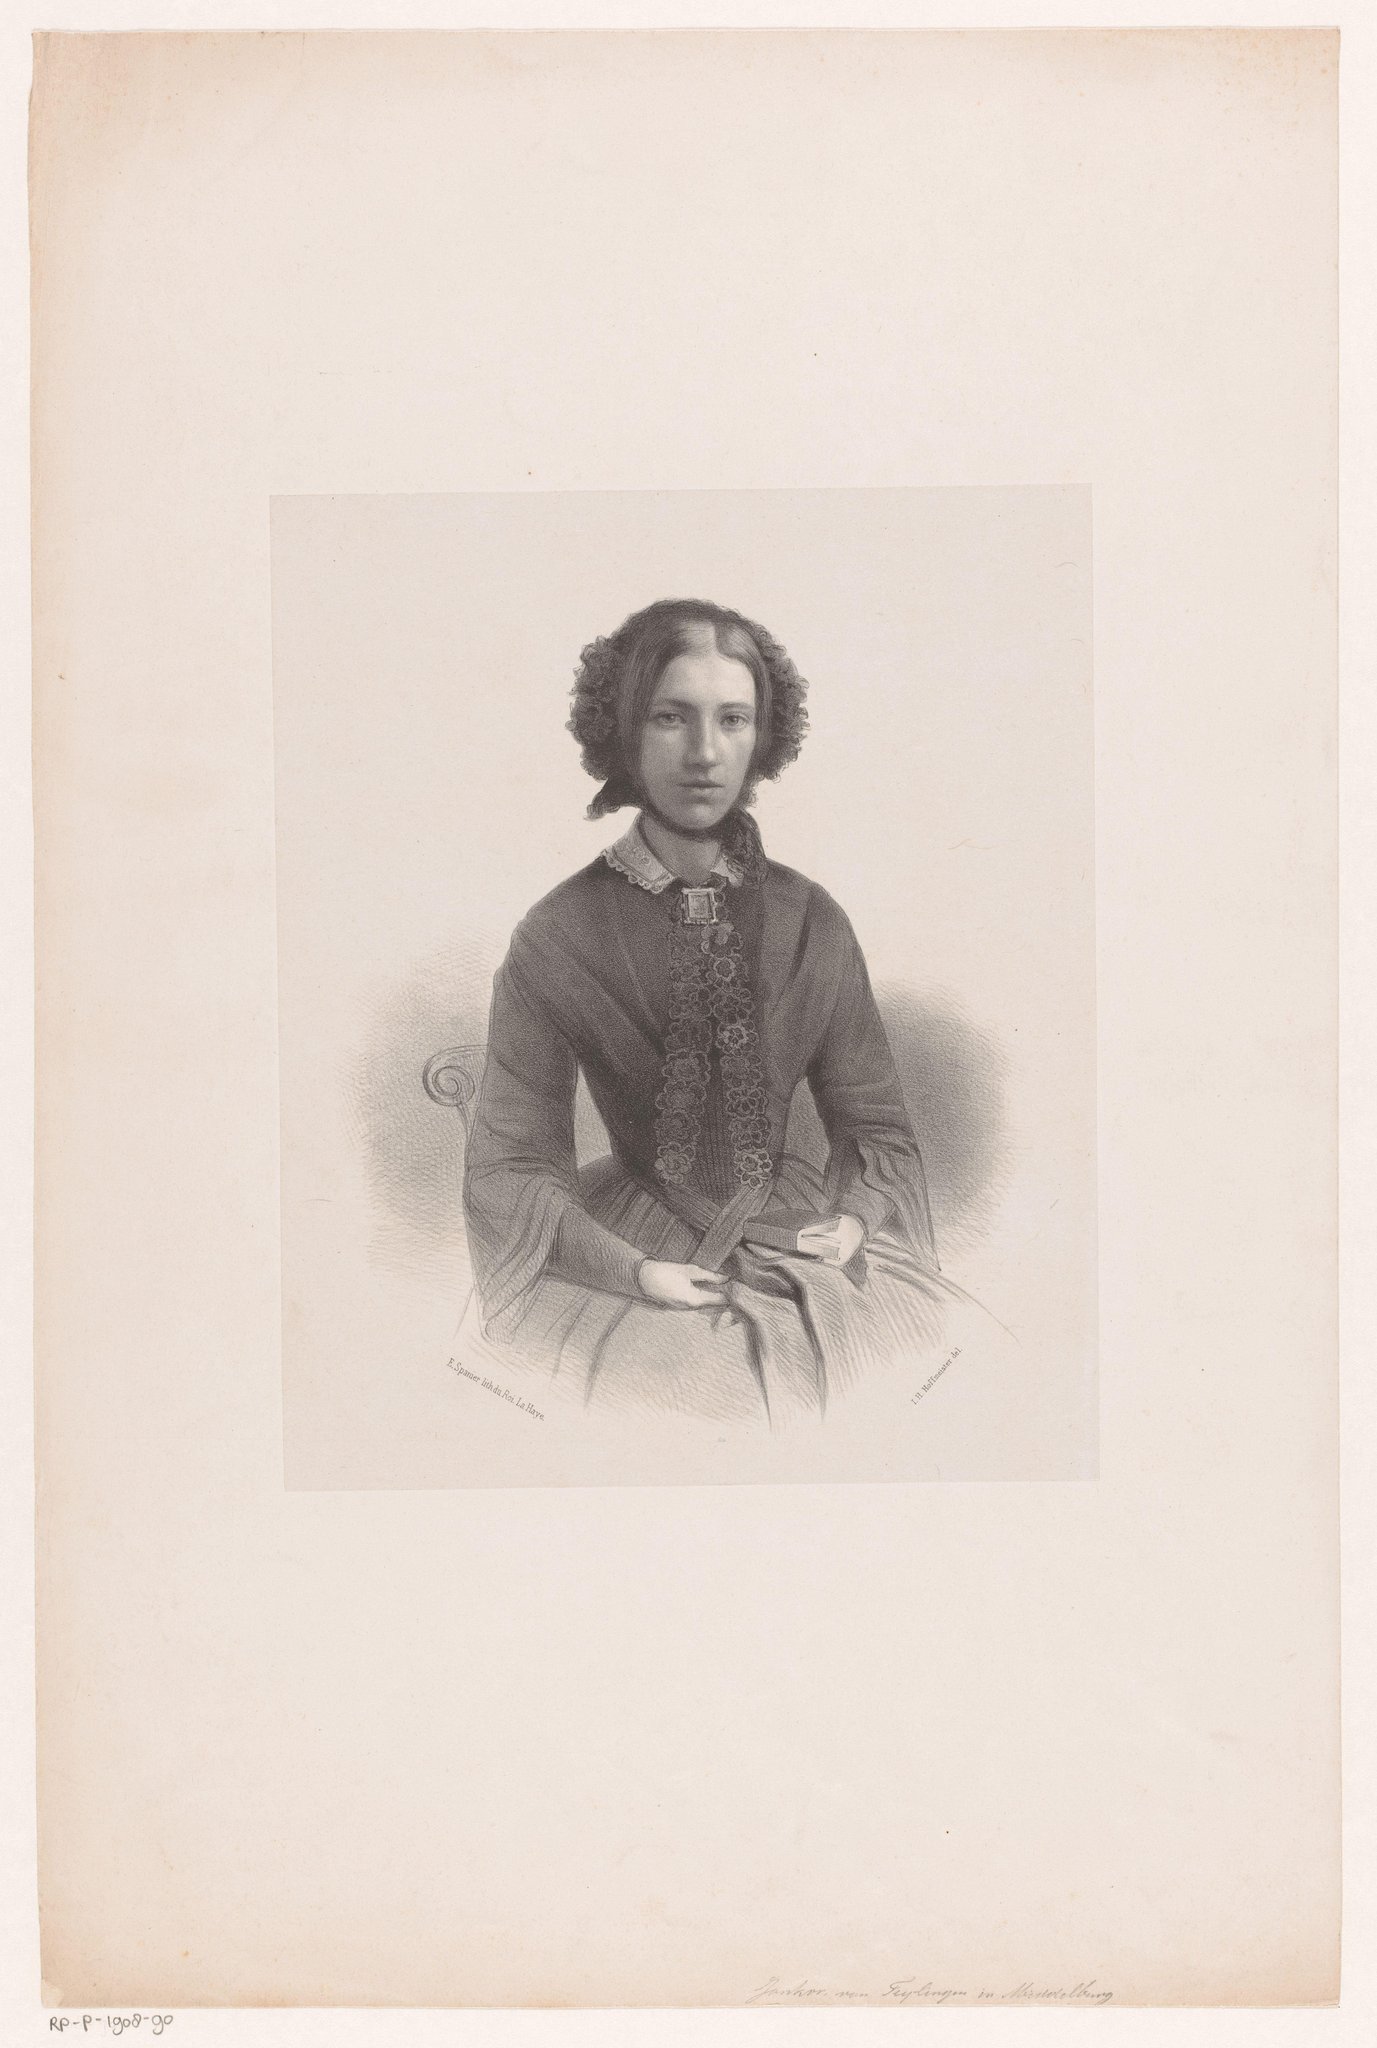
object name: print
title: Portret van een onbekende vrouw, mogelijk jonkvrouw Van Teylingen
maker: johan hendrik hoffmeister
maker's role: print maker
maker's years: 1823-1904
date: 1851-1883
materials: paper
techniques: lithograph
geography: the hague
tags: historical persons - bb - woman (+ (full) bust portrait)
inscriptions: collector's mark: Lugt 2228